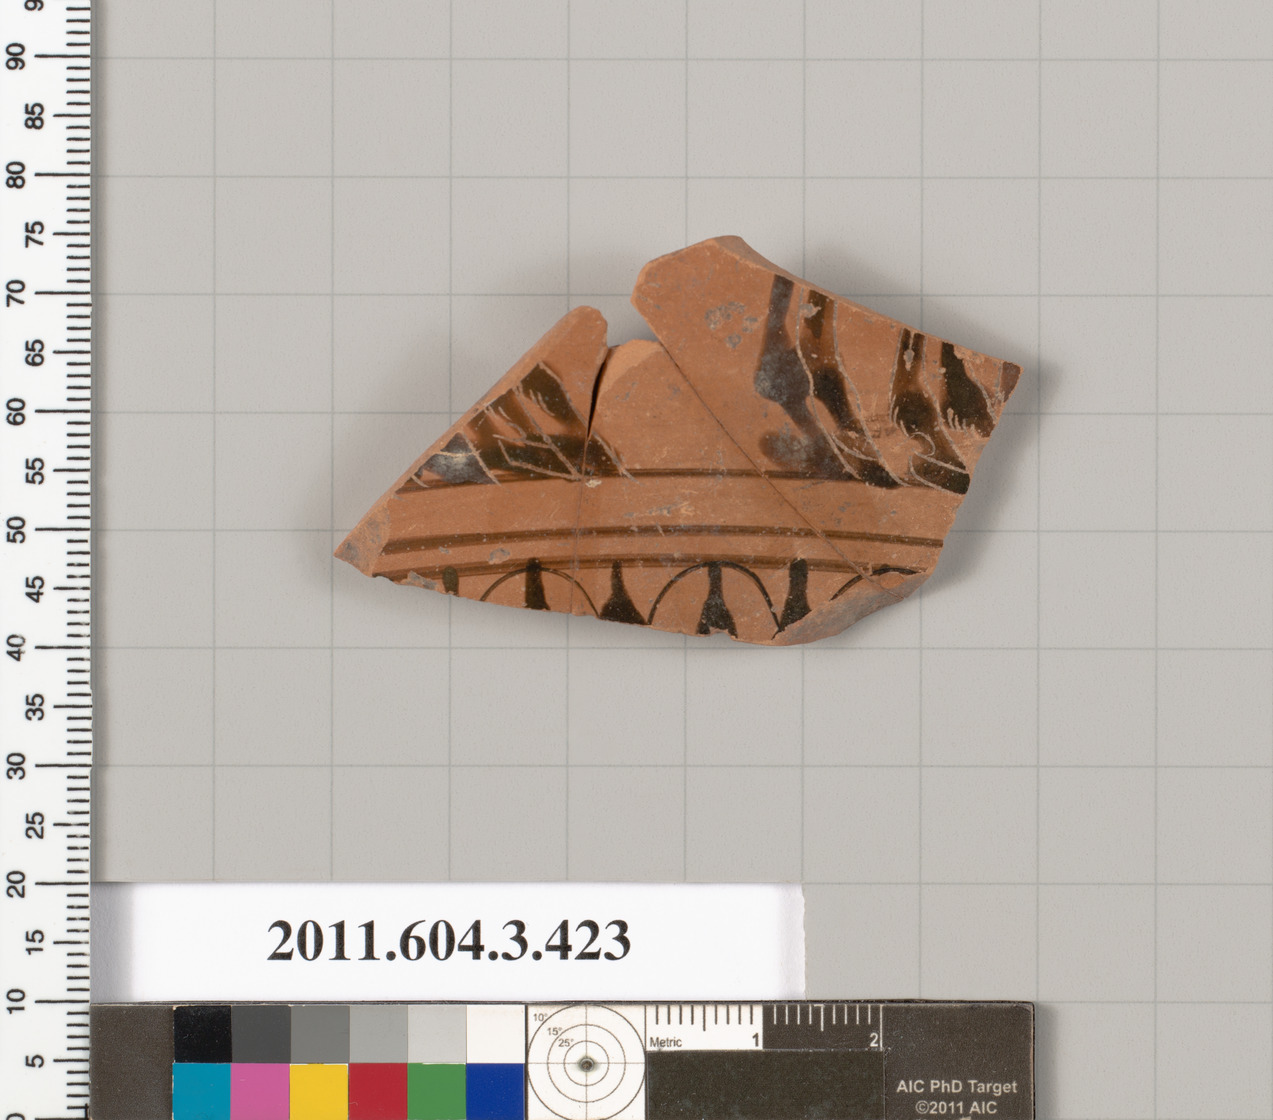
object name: neck amphora fragment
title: Terracotta fragment of a neck-amphora (jar)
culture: greek, attic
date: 520-510 BCE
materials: terracotta